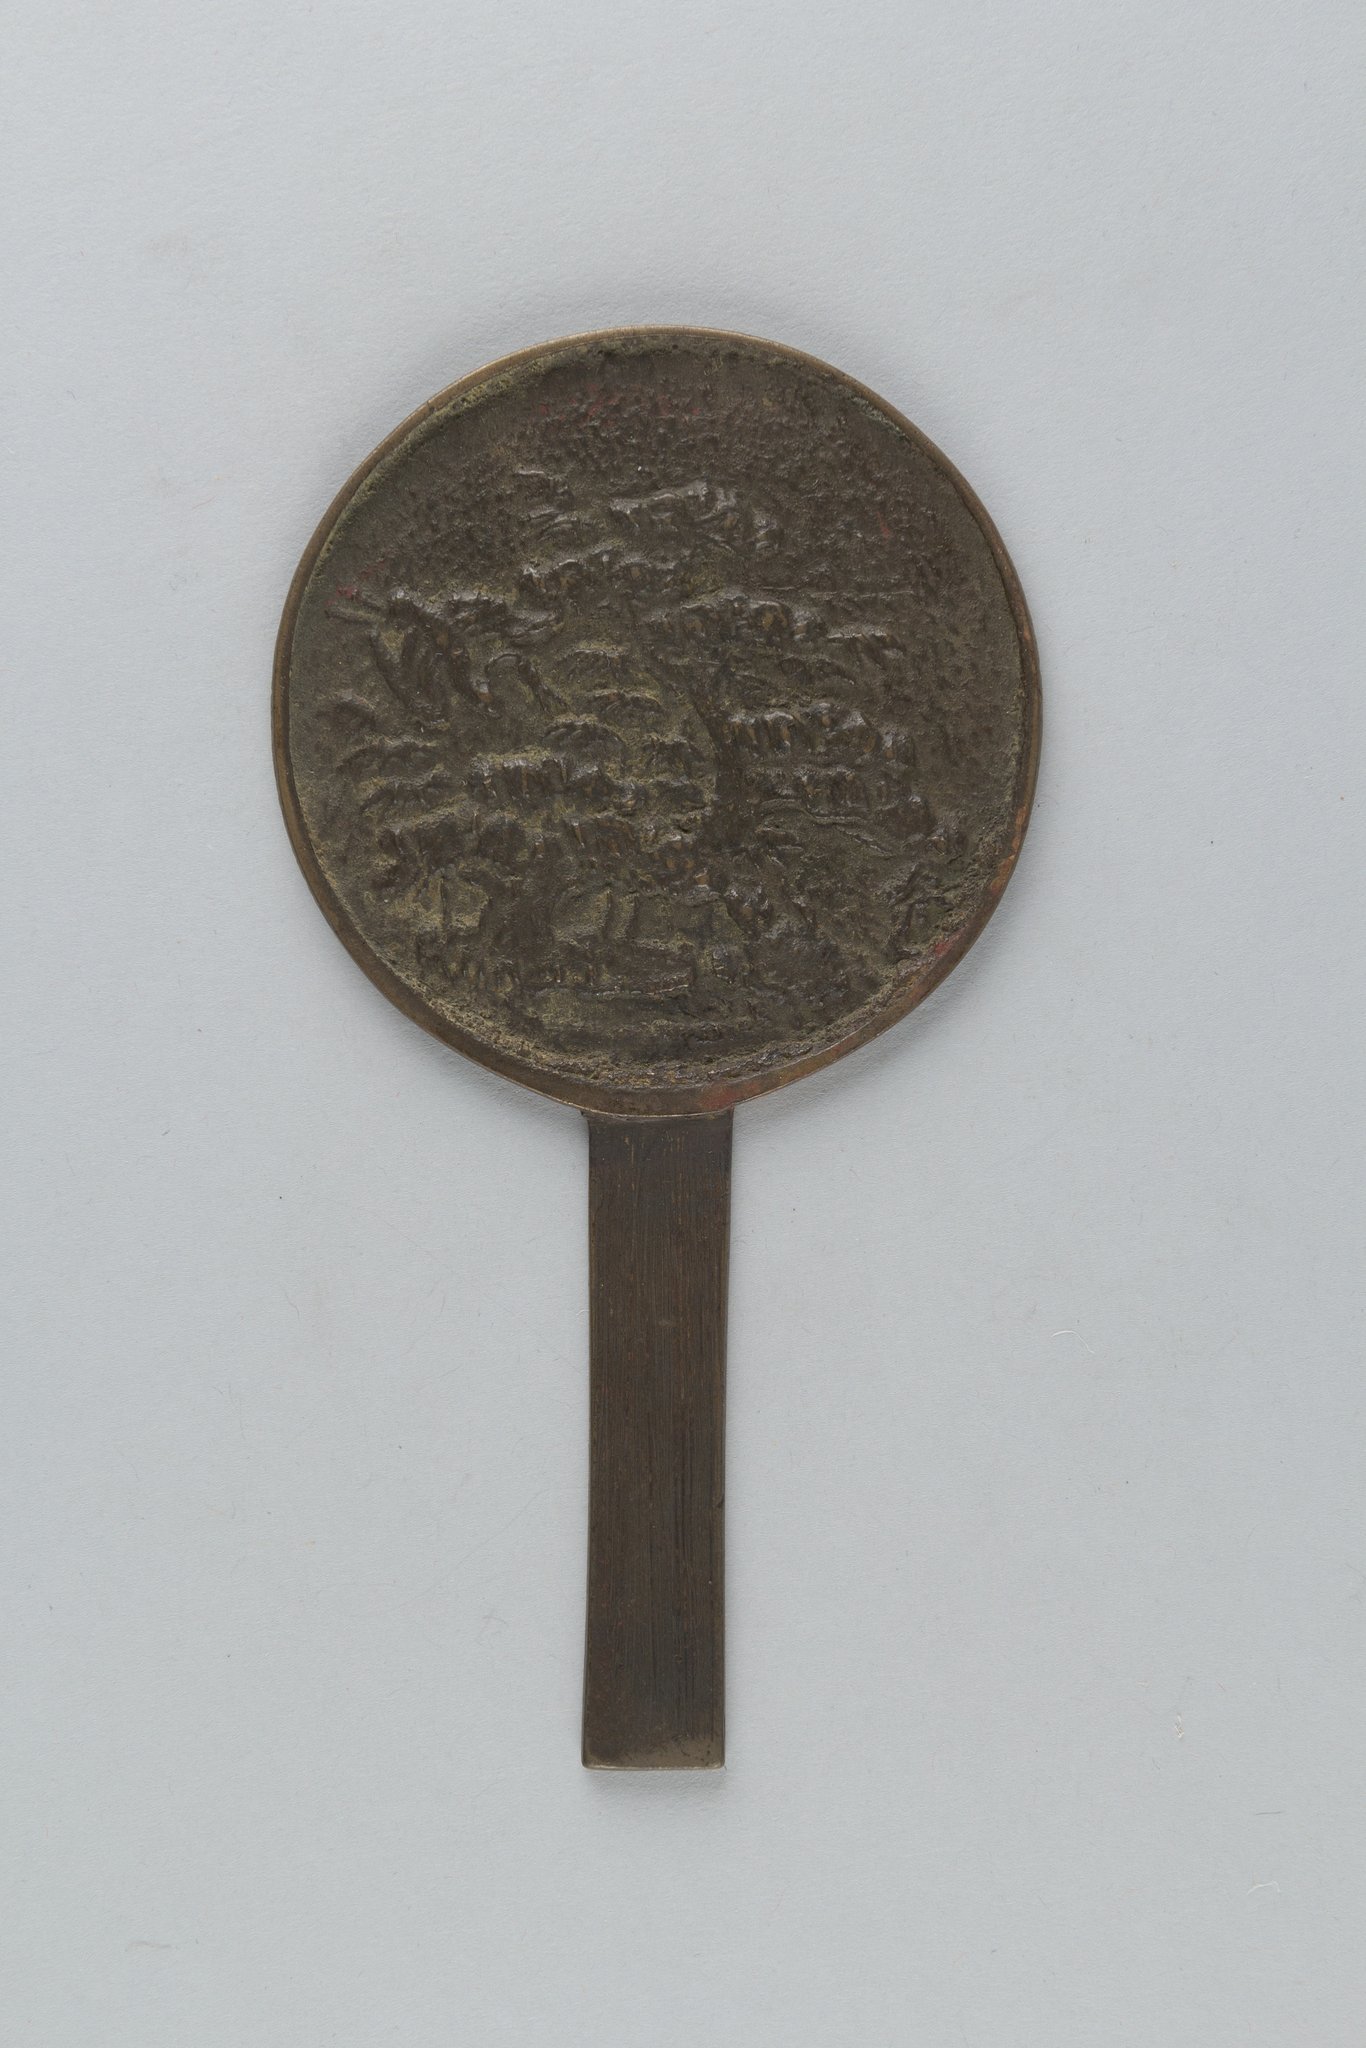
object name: mirror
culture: japanese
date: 1801-1833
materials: brass